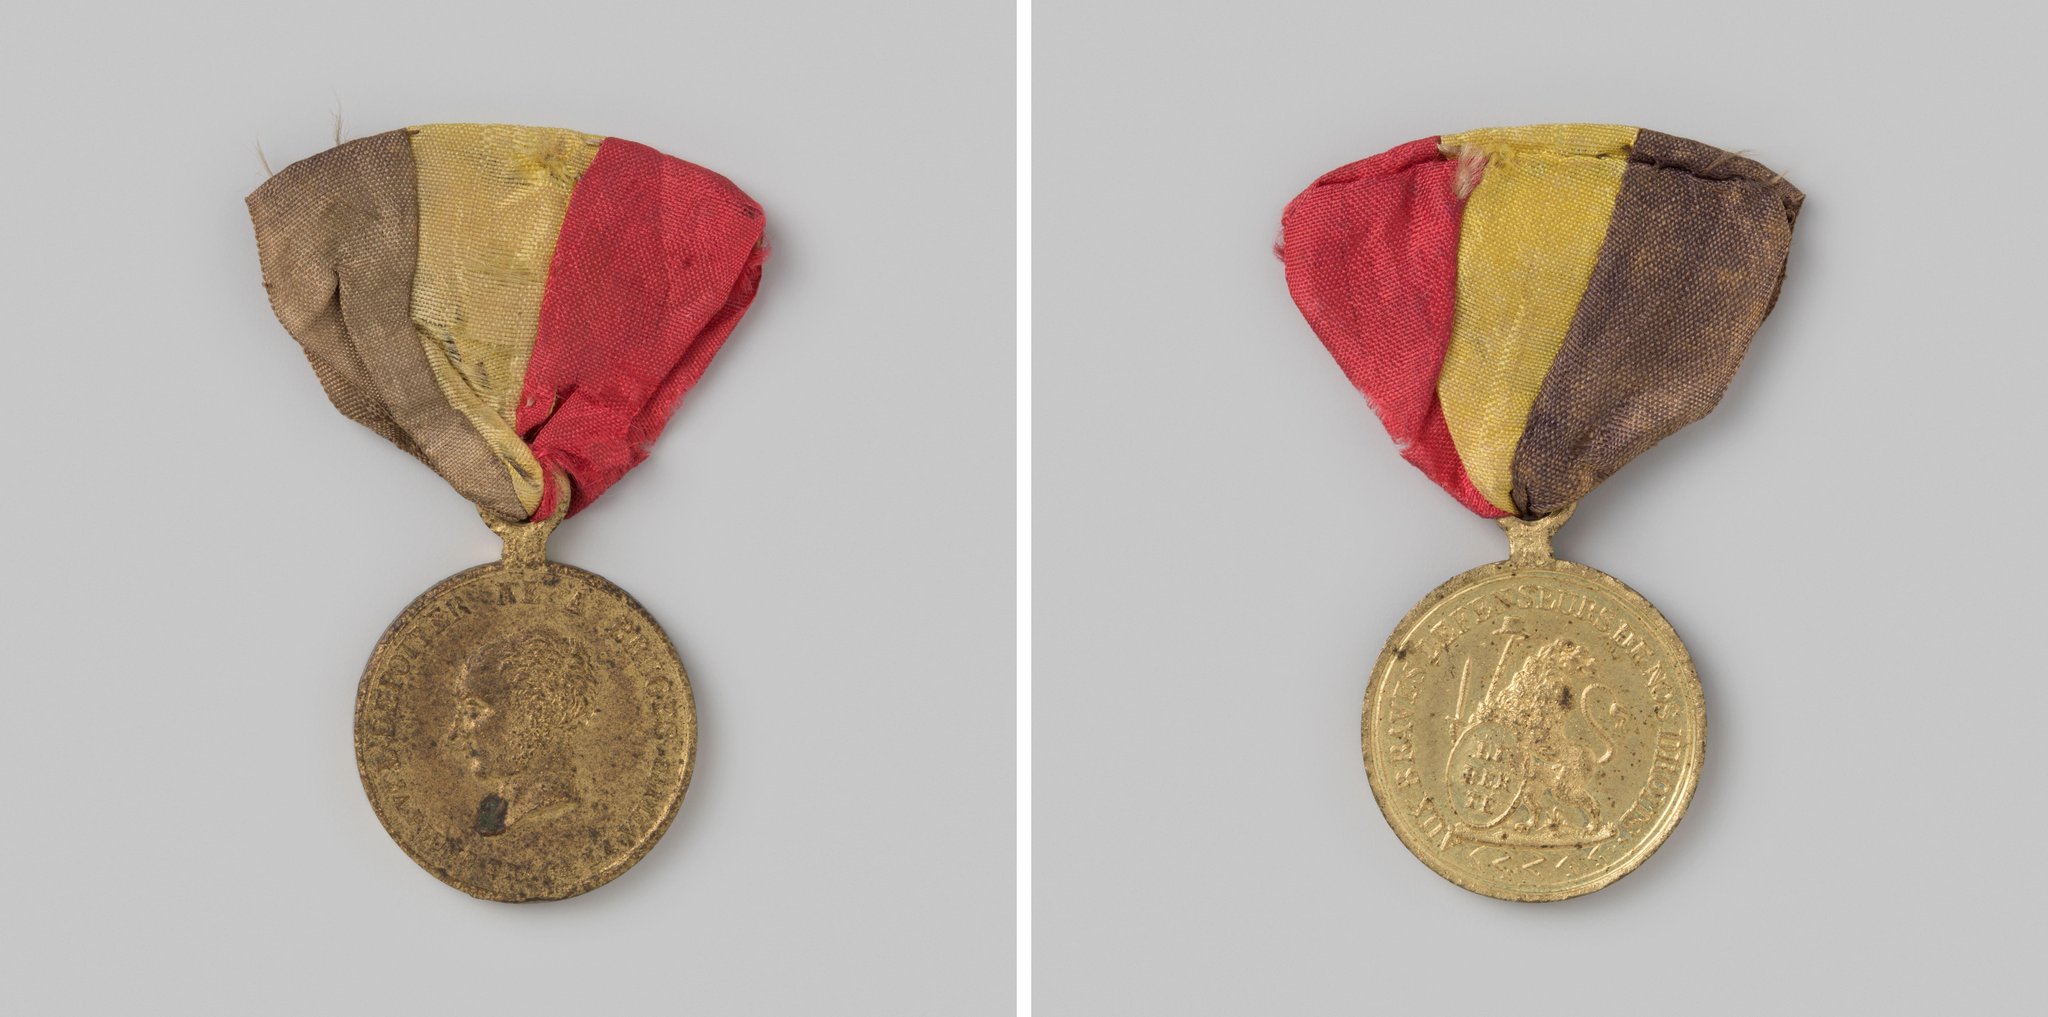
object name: insignia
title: Louis Joseph de Potter, verdediger van de onafhankelijkheid van België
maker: Anonymous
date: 1830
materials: copper, textile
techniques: striking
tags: bruges, belgium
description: Koperen draagteken aan draagoog en zwart-geel-rood lint. Voorzijde: borststuk man binnen omschrift. Keerzijde: leeuw met vrijheidshoed op speer, zwaard en wapenschild binnen omschrift